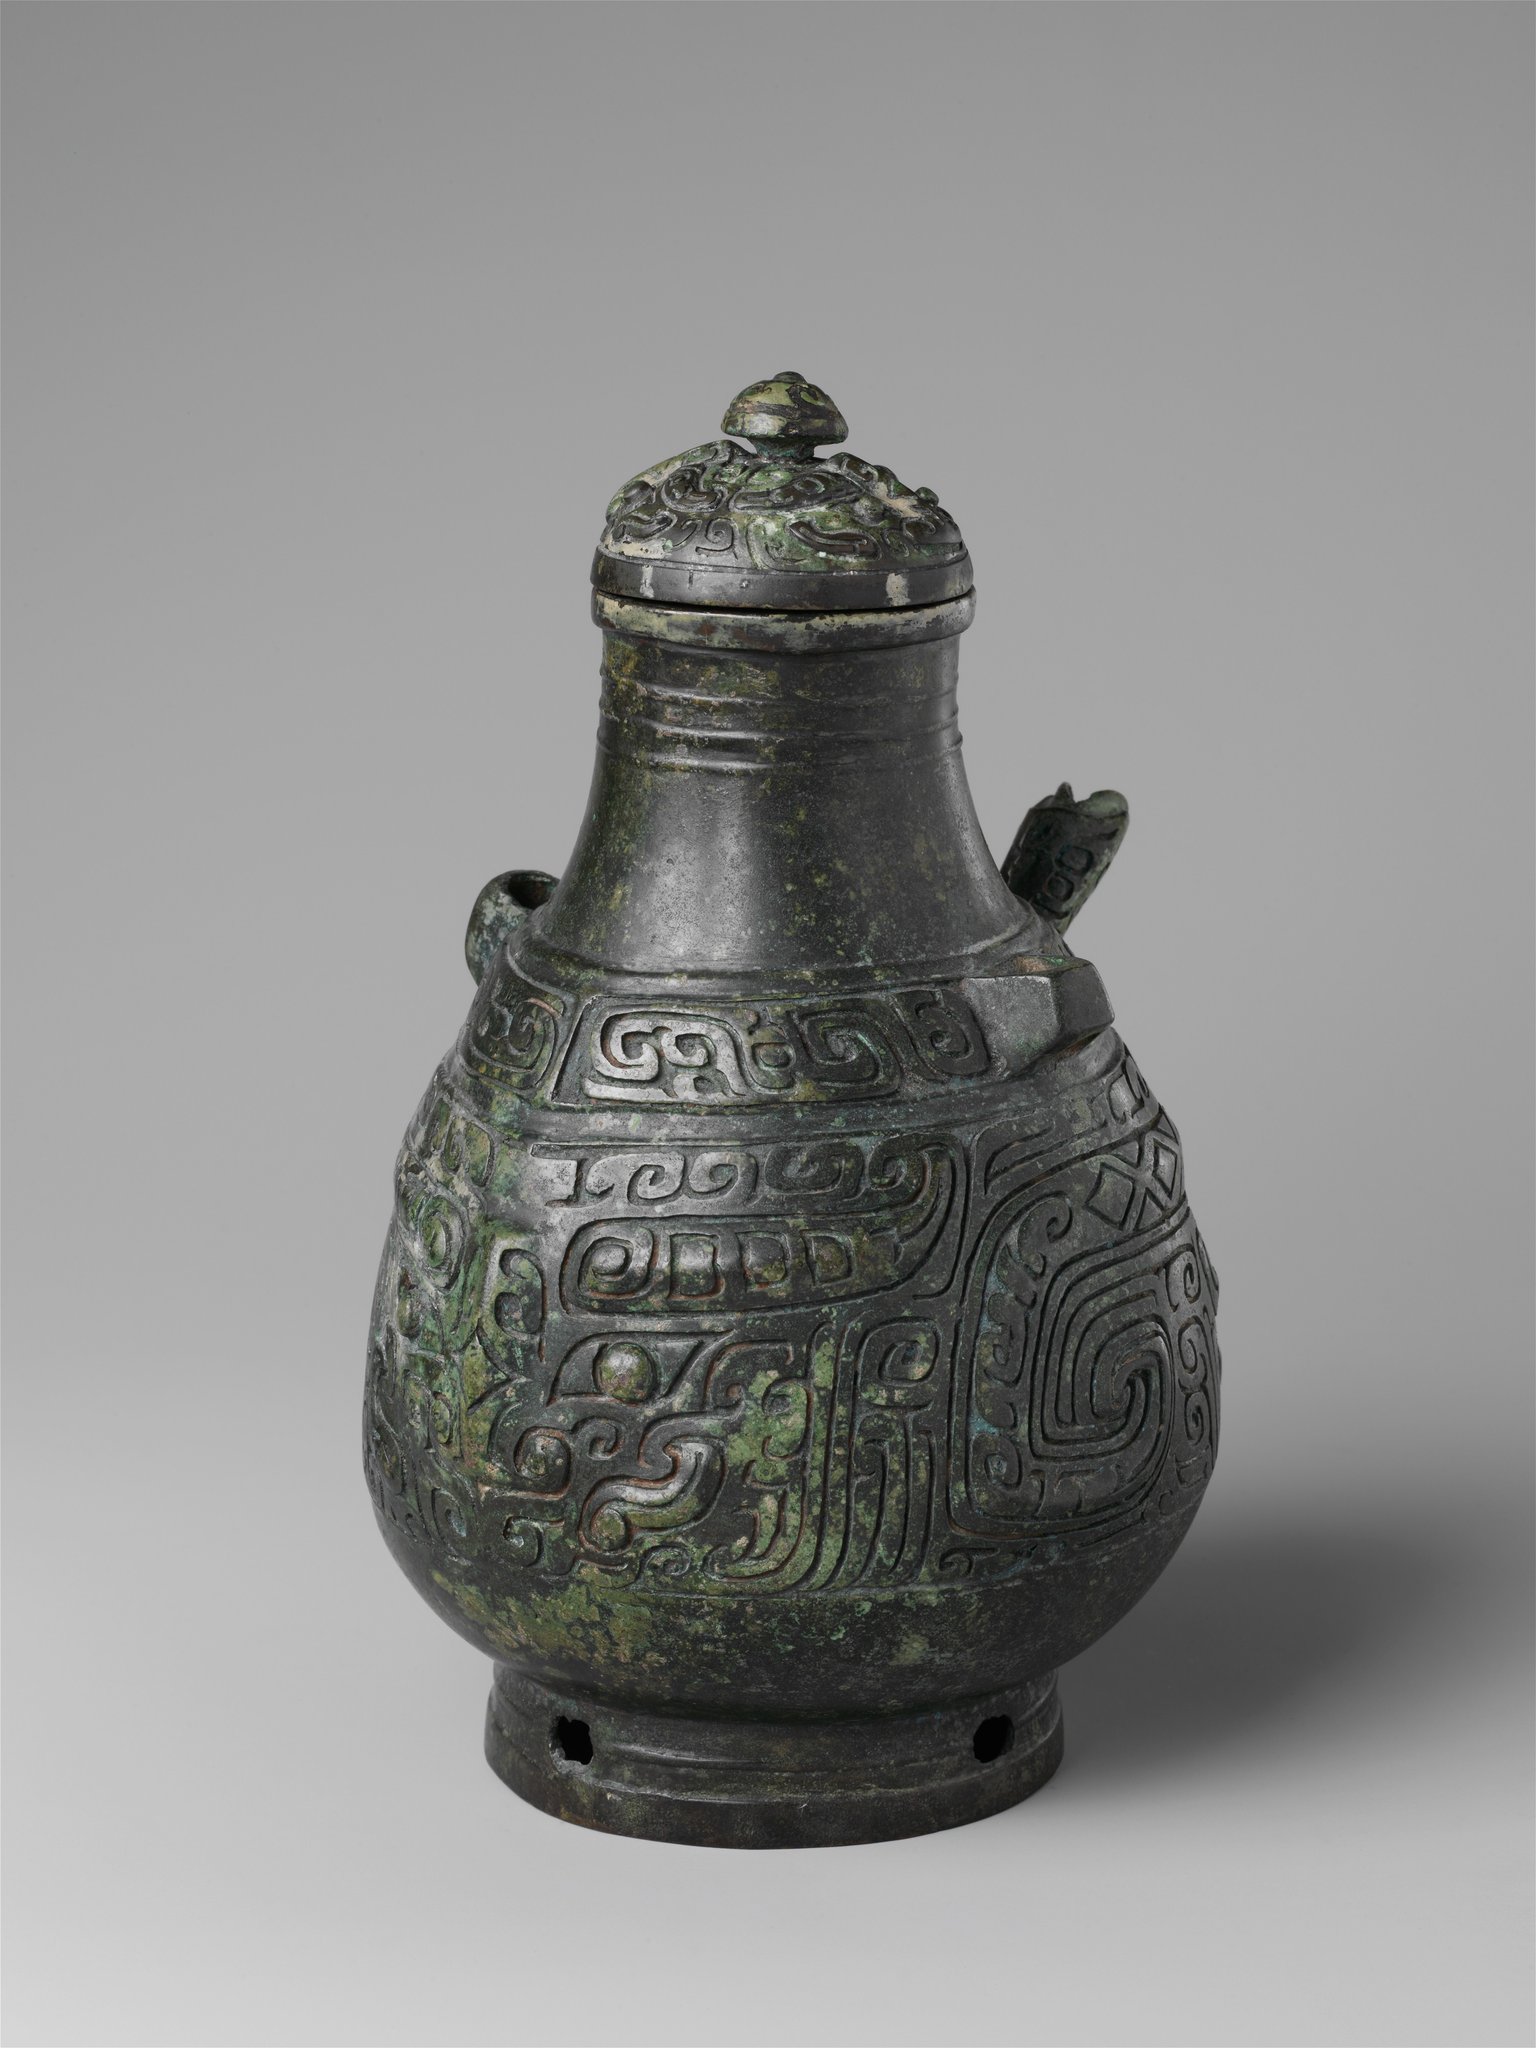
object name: water container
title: Spouted water container (He)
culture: chinese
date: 1334-1301 BCE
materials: bronze